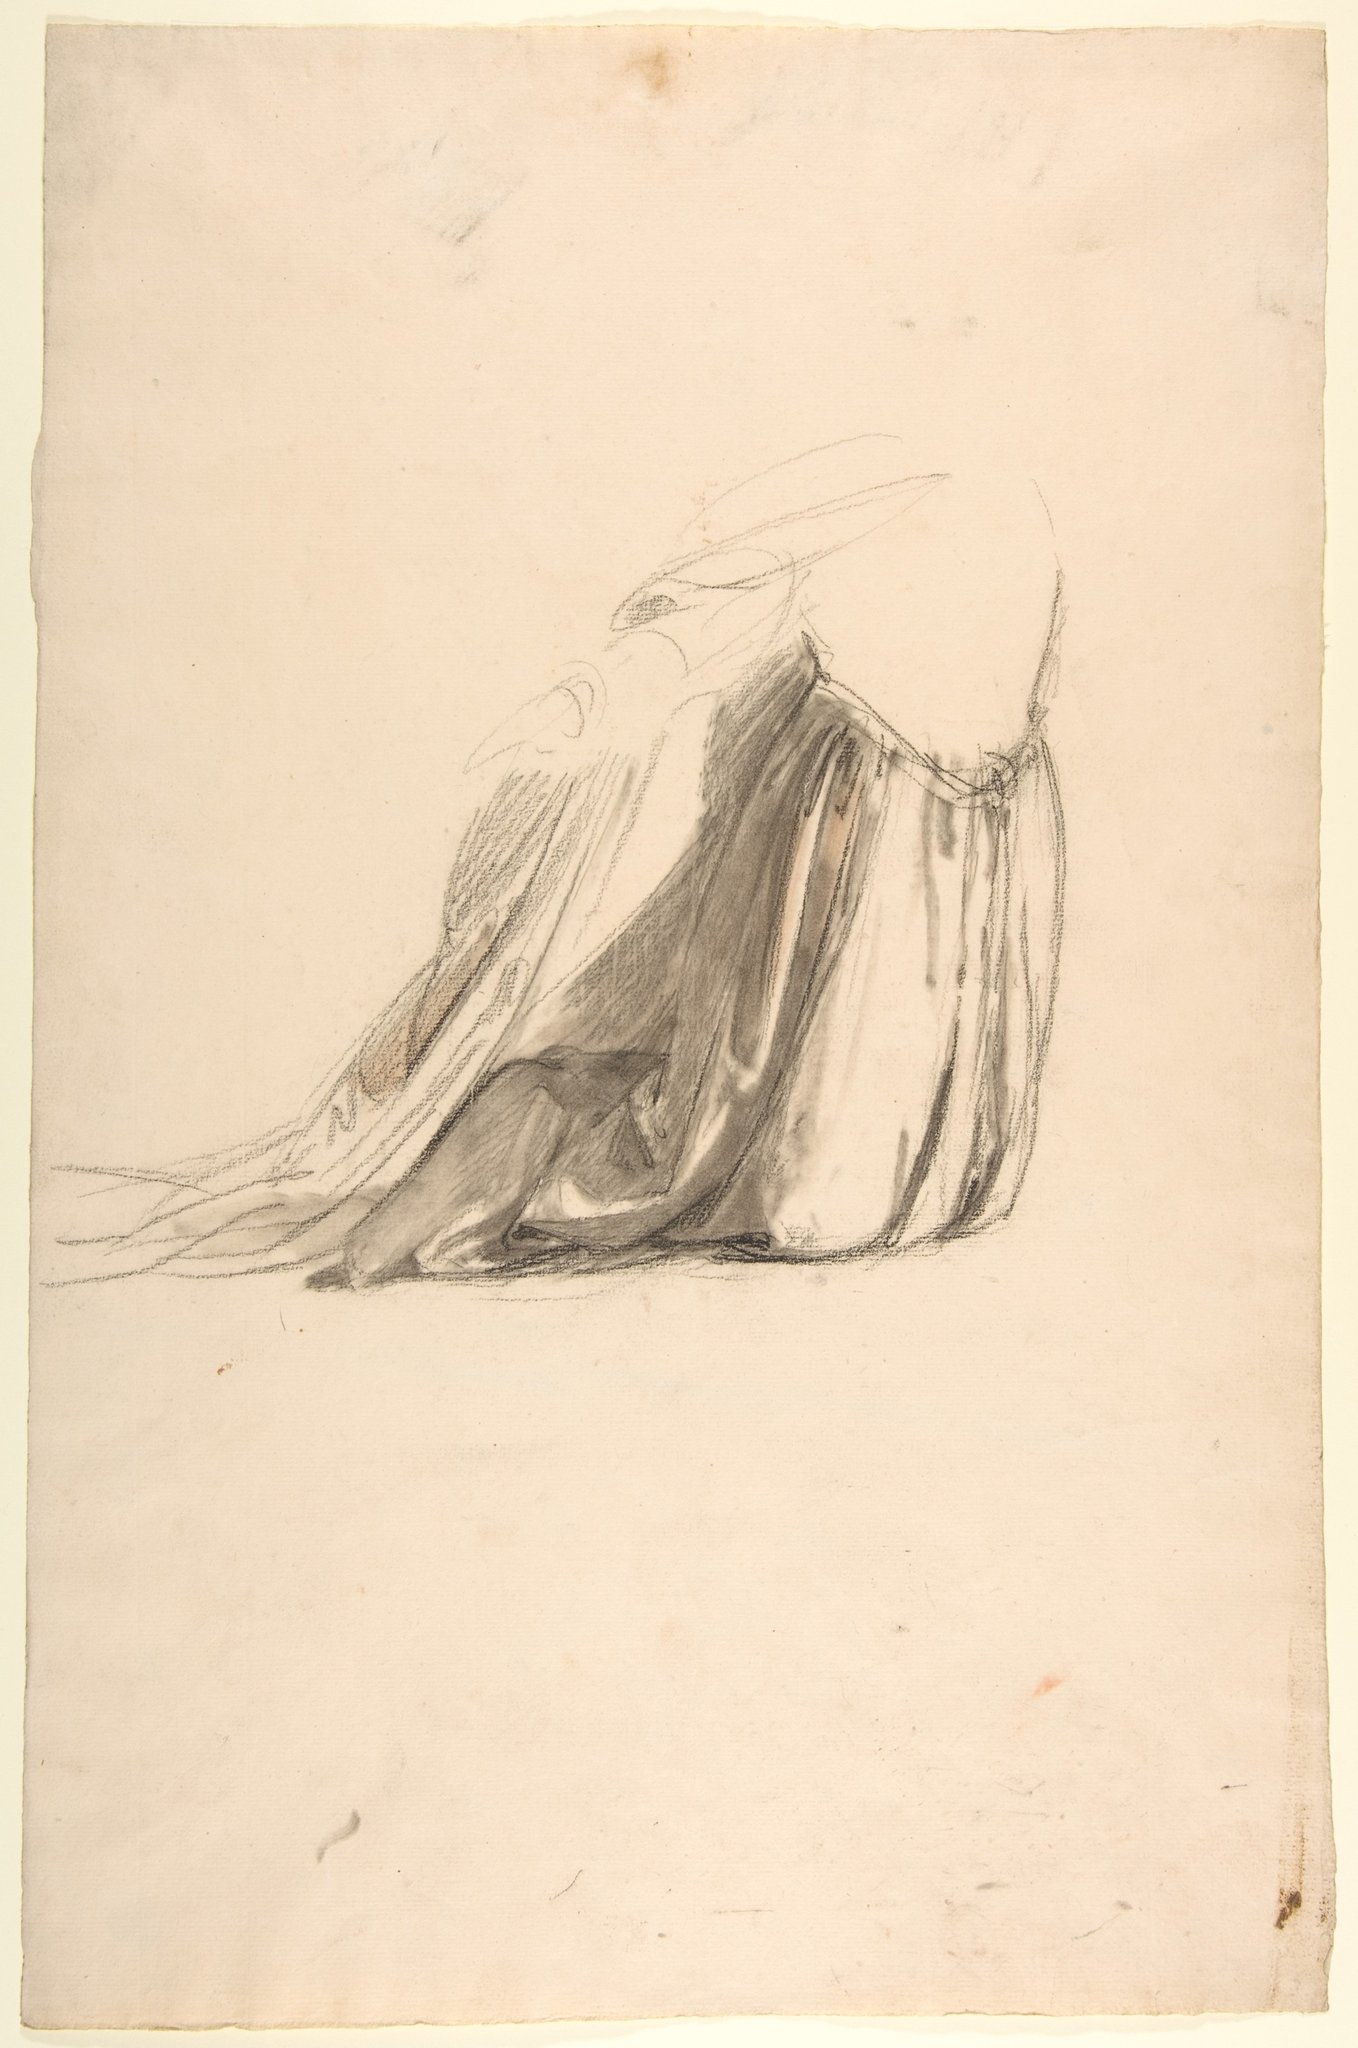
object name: drawing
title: Drapery Study for Sainte Clotilde (middle register; study for wall paintings in the Chapel of Saint Remi, Sainte-Clotilde, Paris, 1858)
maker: isidore pils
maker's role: artist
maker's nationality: french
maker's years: 1813-1875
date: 1801-1900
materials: chalk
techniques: stumping